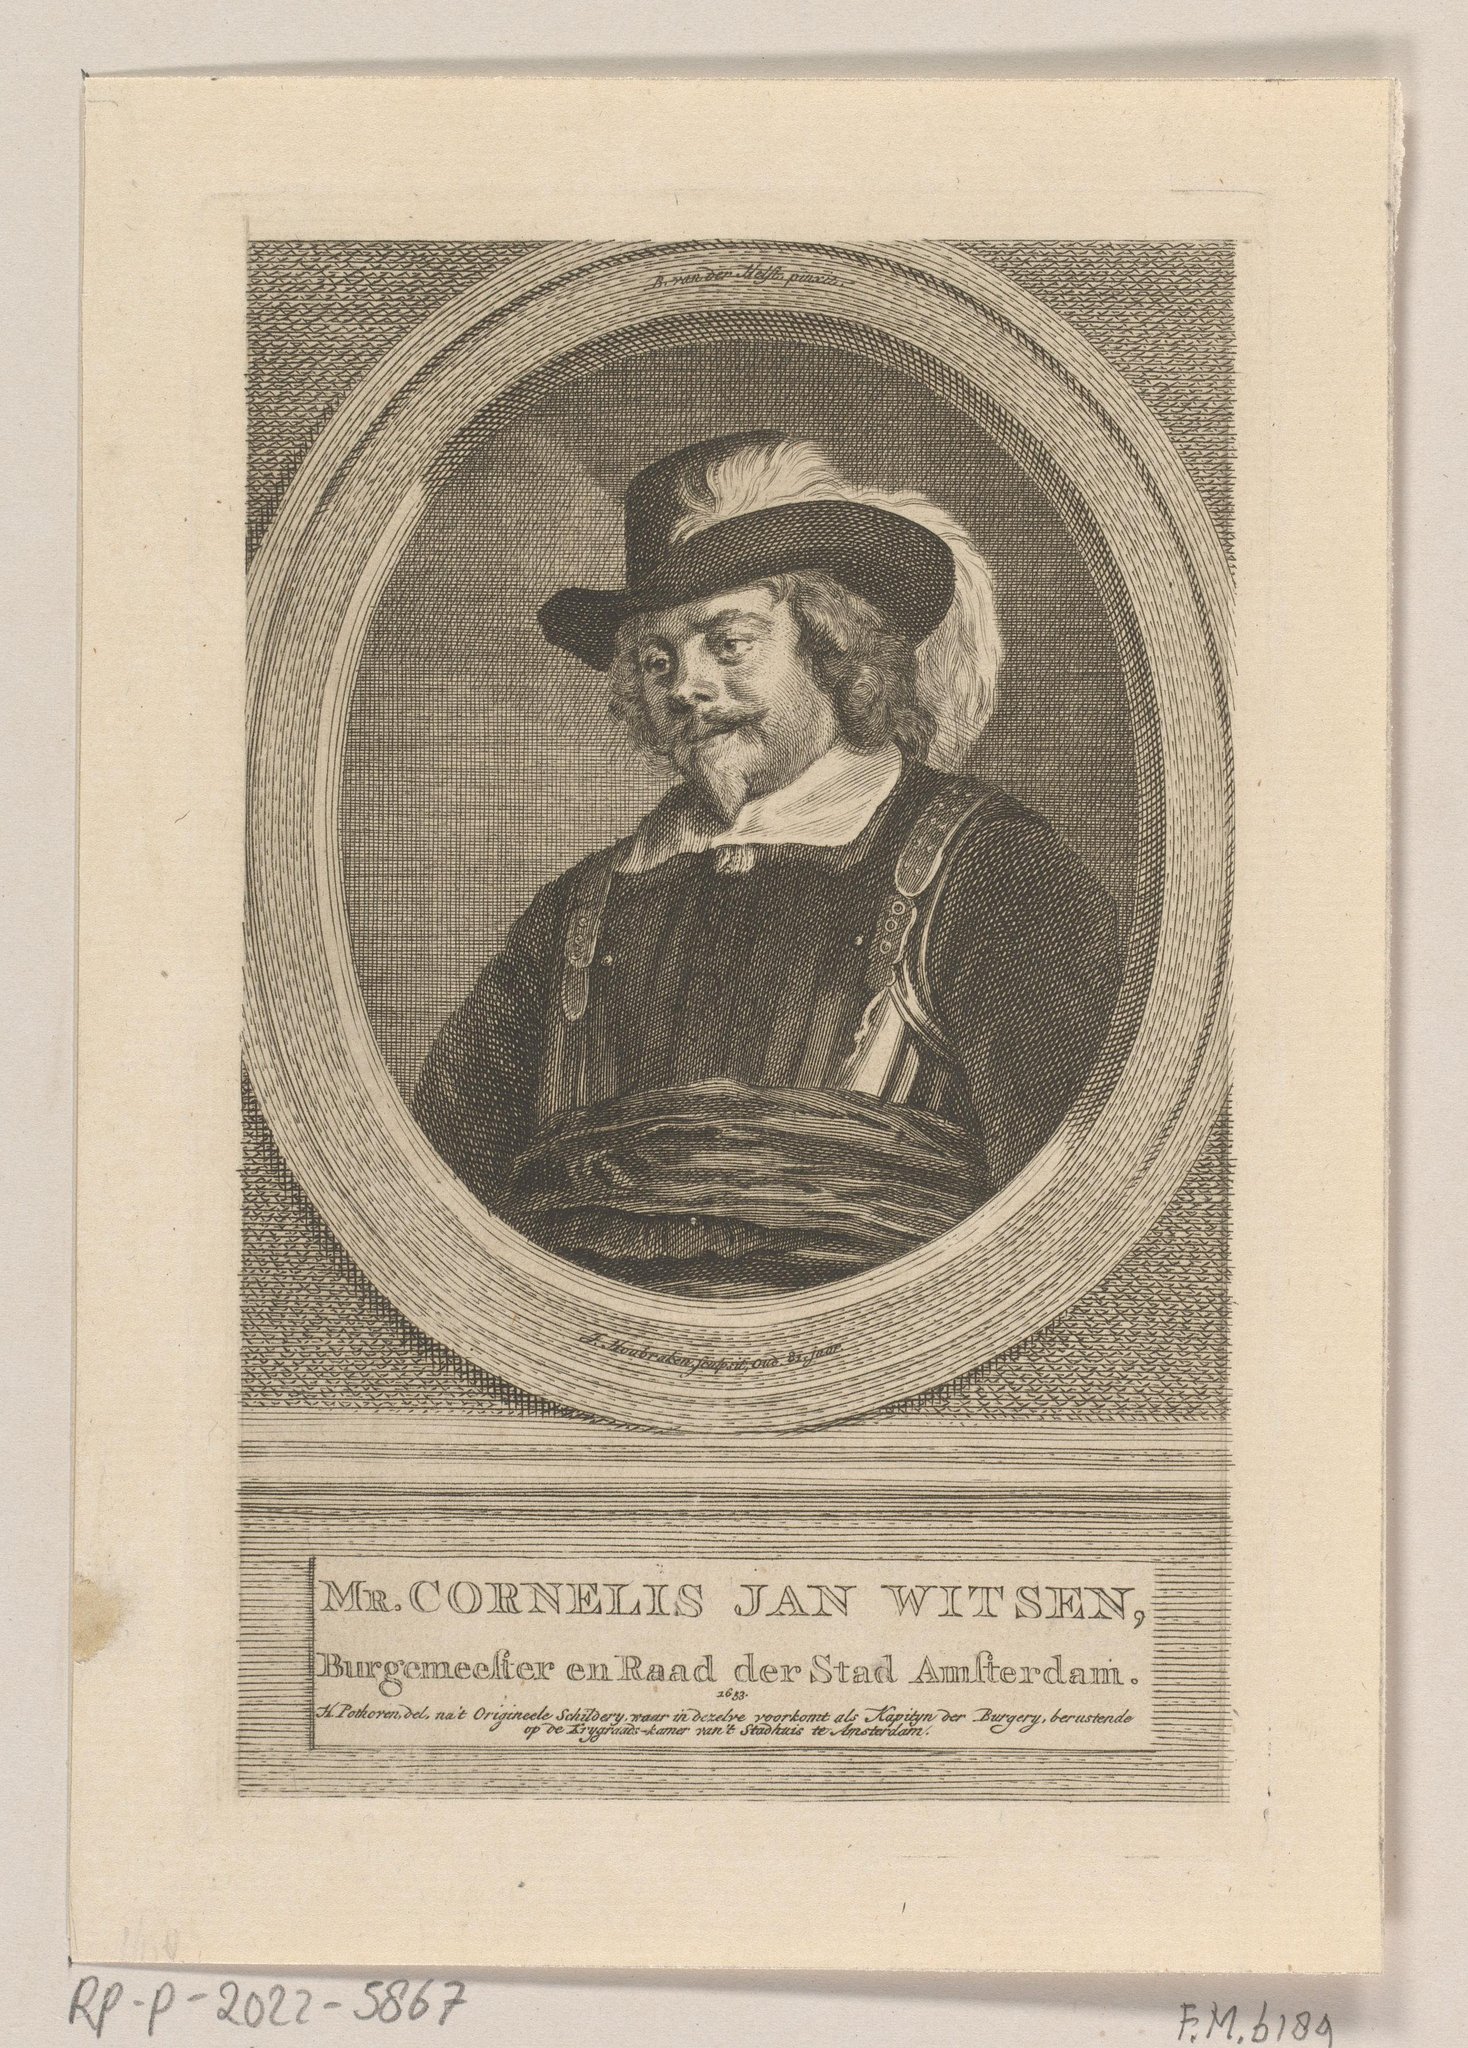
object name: print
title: Portret van Cornelis Witsen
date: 1779-1780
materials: paper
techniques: engraving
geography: amsterdam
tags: cornelis witsen, mayor, burgomaster, historical persons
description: De prent is gemaakt ca. 1779-1780 en kon worden ingevoegd in: Wagenaar, Jan. Amsterdam in zyne opkomst, aanwas, geschiedenissen, (...). Amsterdam: Isaak Tirion, 1765, vol. 7. De prenten zijn tussen 1765 en 1786 in dit boek gevoegd. Zie: Compleete lyst of register van alle de portraiten en plaaten, (...). Amsterdam: A. van der Kroe en A. Capel, 1786.